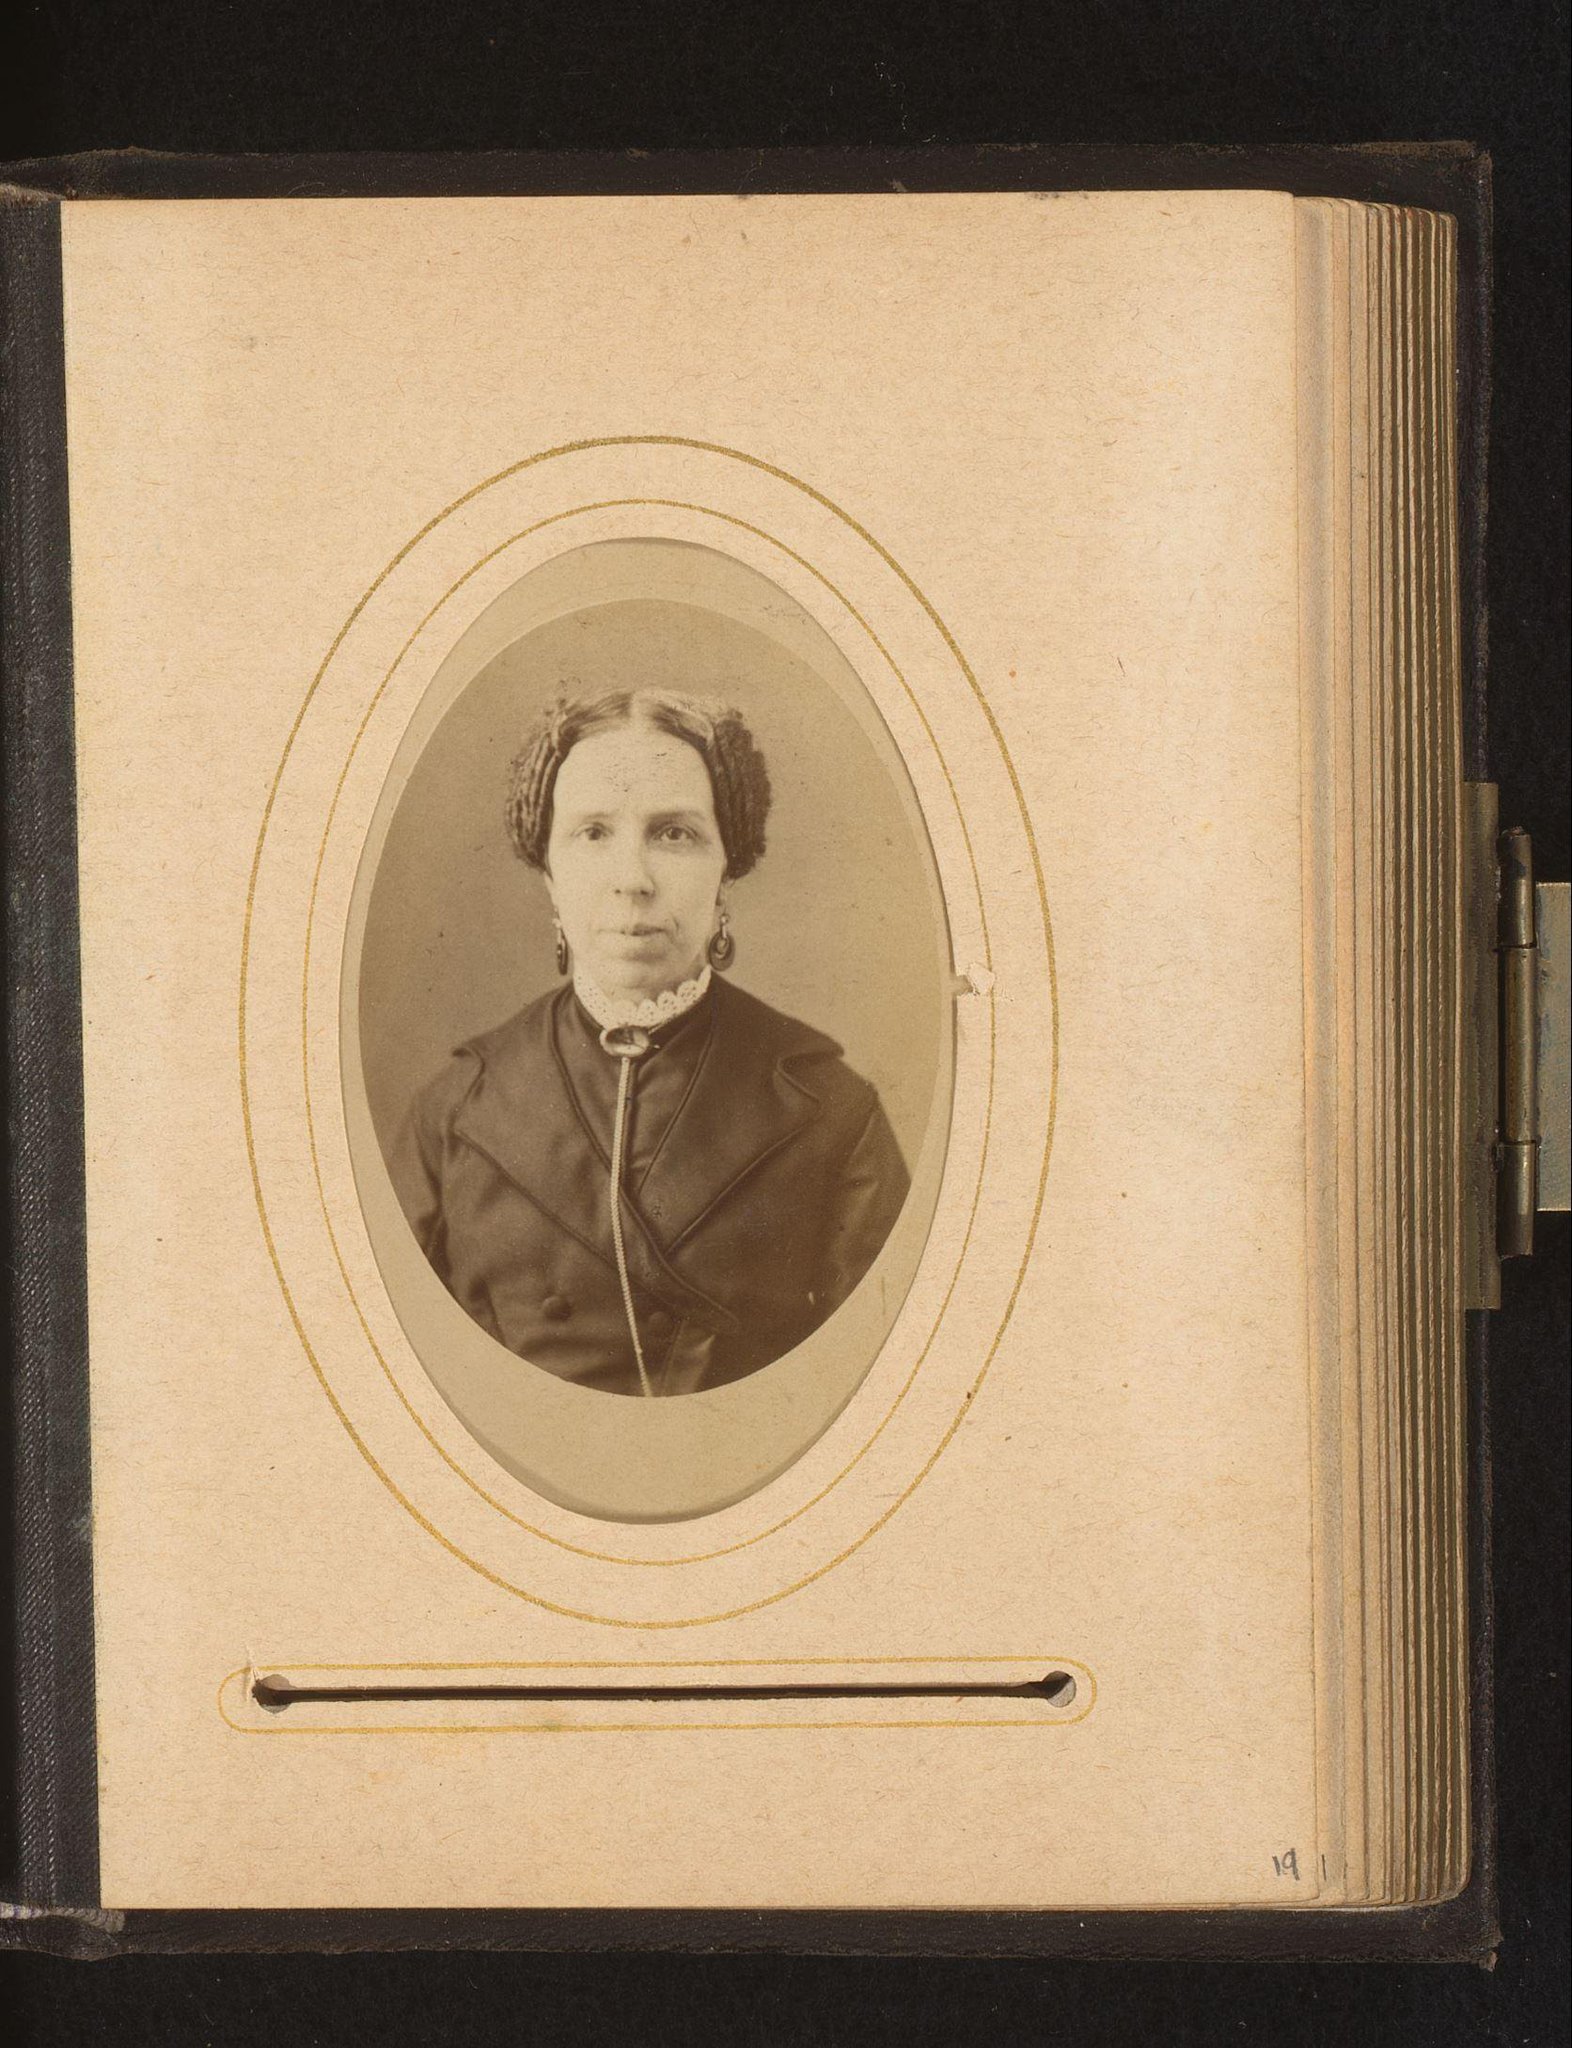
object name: carte de visite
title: Portret van een vrouw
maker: jan george mulder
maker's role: fotograaf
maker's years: 1816-1895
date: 1865-1887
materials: cardboard, photographic support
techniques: albumen print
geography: haarlem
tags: historical persons - bb - woman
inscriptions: inscription: ‘Photogr. Atelier/ J.G. Mulder/ Lange Bagijnestraat/ over de Israëlitische Kerk/ Haarlem’